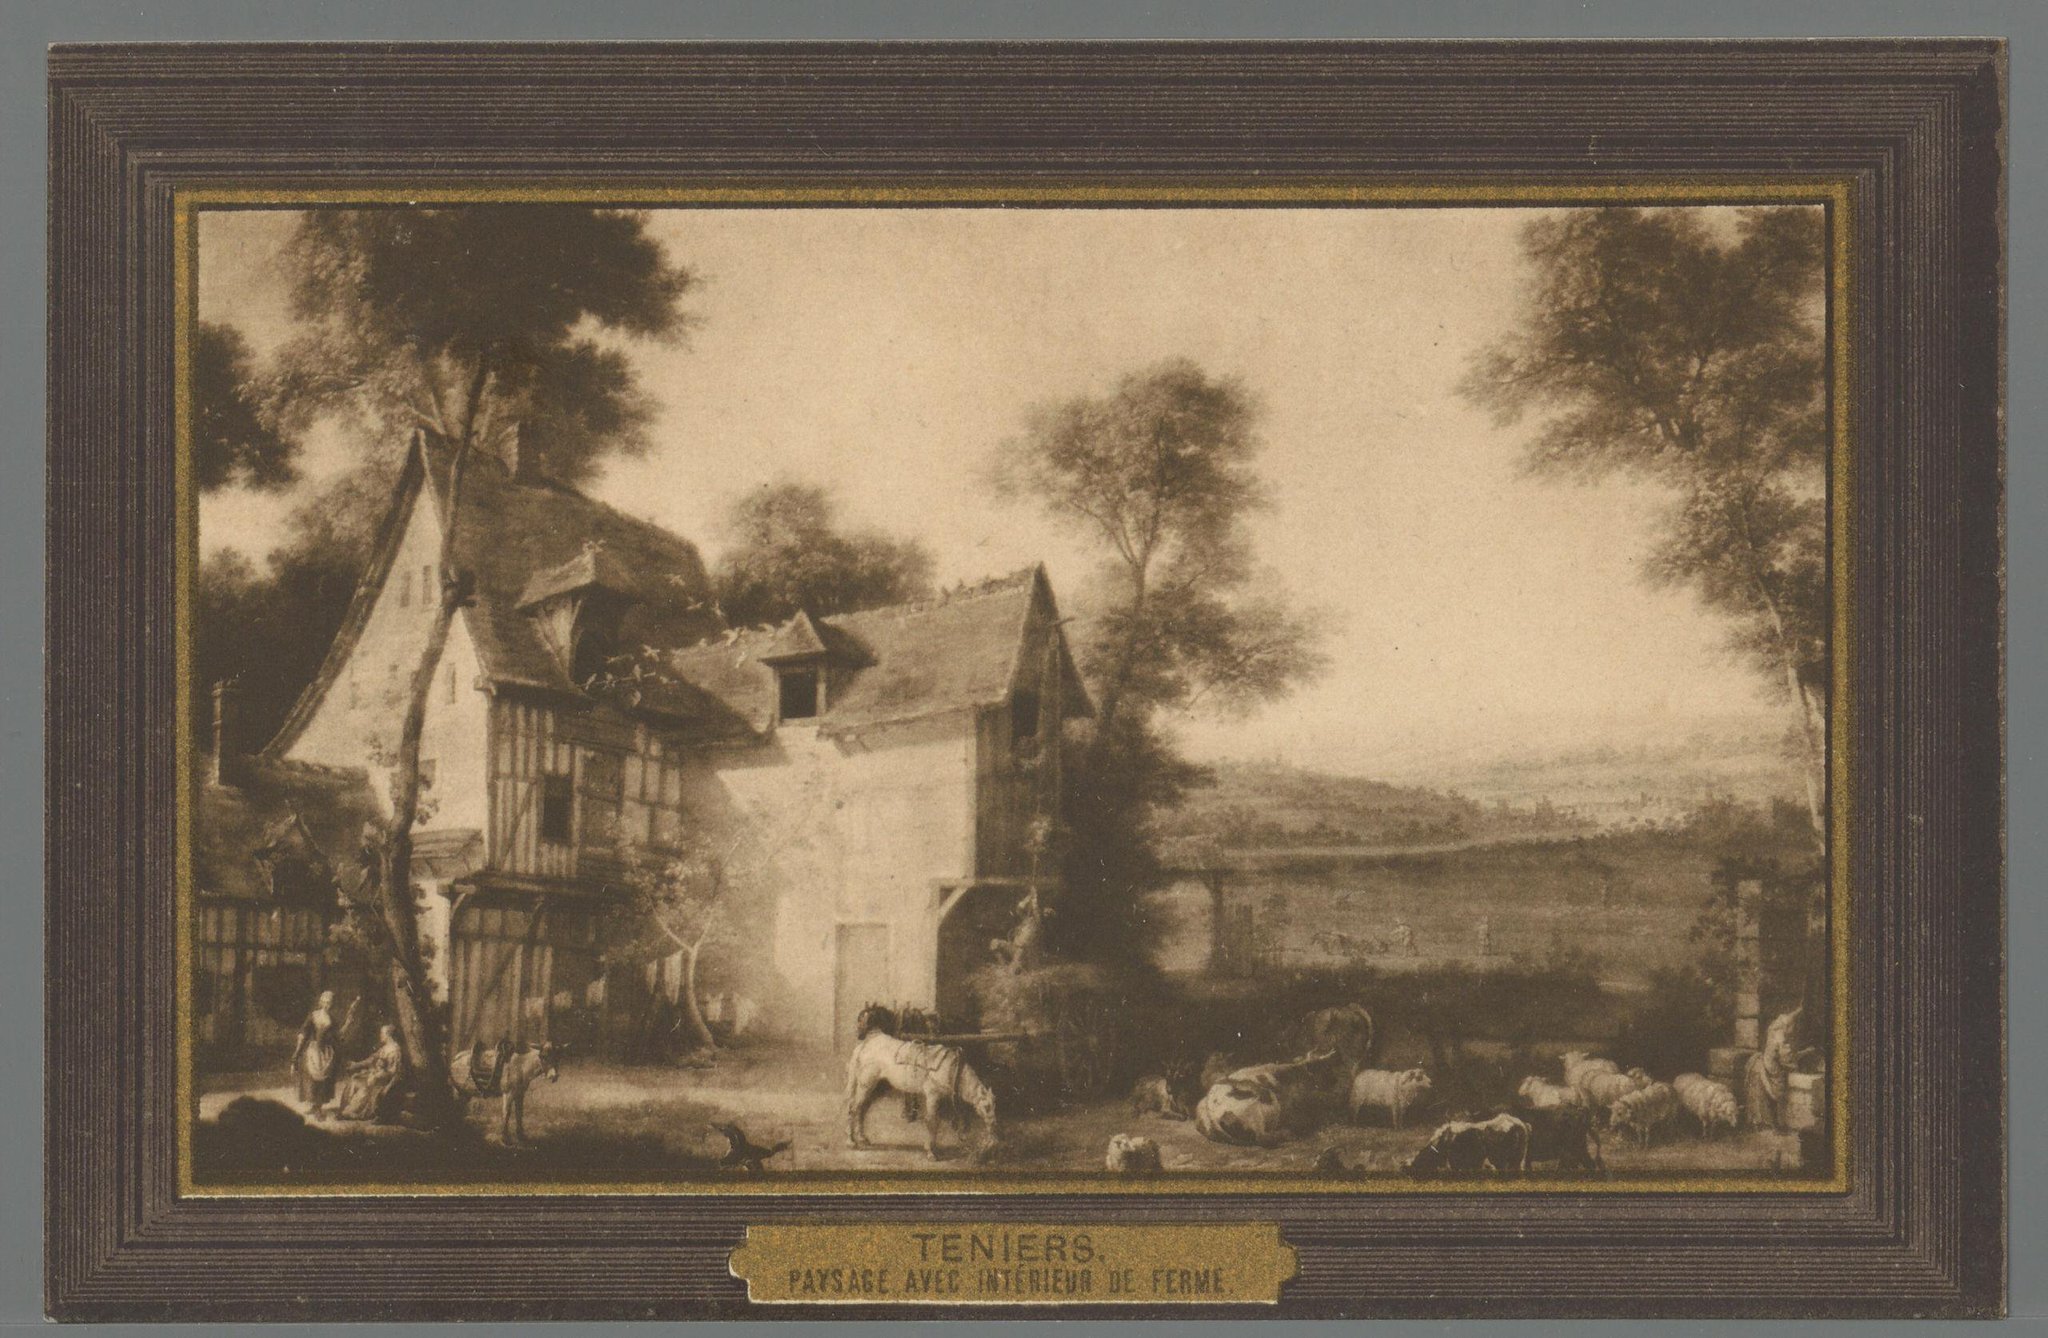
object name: photomechanical print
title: Teniers. Paysage avec intérieur de ferme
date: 1903-1930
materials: cardboard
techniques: photograph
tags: permanent exhibition, museum, picture, painting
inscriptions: collector's mark: ‘AFE v S’, inscription: ‘L. N. Musée du Louvre’